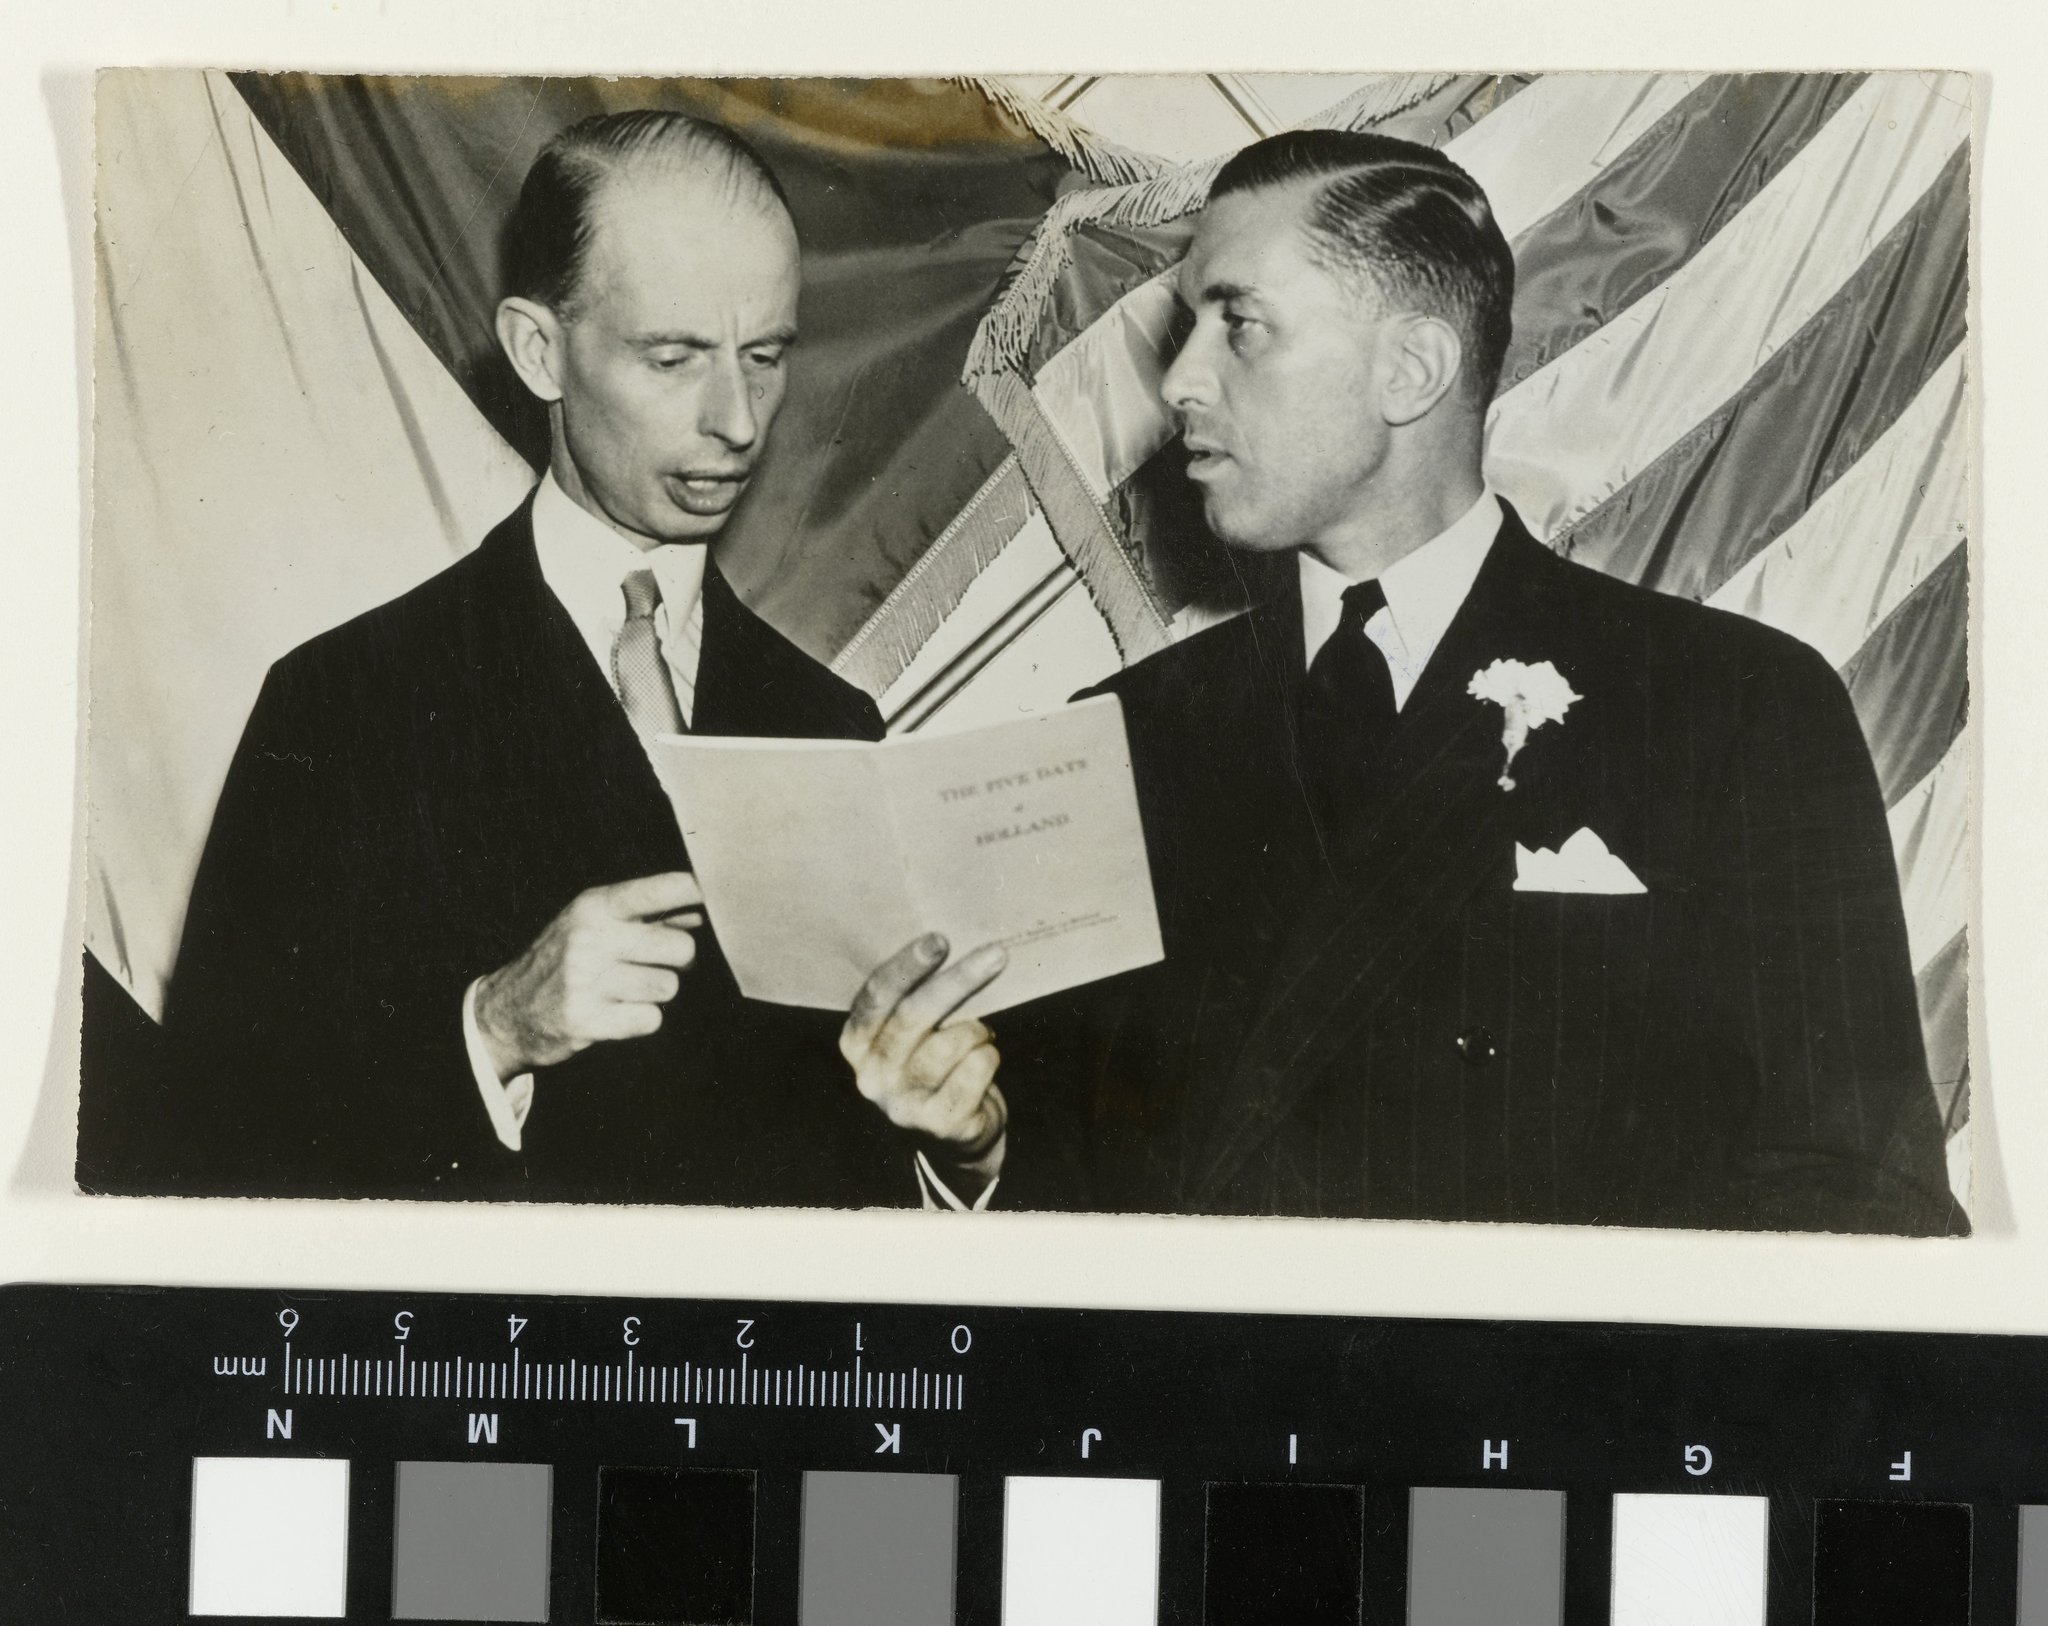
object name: photograph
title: Minister van Buitenlandse Zaken Eelco N. van Kleffens op bezoek in de Verenigde Staten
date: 1940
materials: photographic support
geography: new york city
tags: new york (city)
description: Eelco Nicolaas van Kleffens (1894-1983) was tijdens de Tweede Wereldoorlog de Nederlandse minister van buitenlandse zaken in Londen. Op de foto staat hij links. De foto is gemaakt tijdens het bezoek wat hij op 13 juni 1941 bracht aan Dr. N.A.C. Slotemaker de Bruine in de Verenigde Staten. De heer Slotemaker de Bruine was de directeur van het Netherlands Information Bureau te New York. Van Kleffens werd in 1939 Minister van Buitenlandse Zaken in het kabinet-De Geer II. Hij zette de toenmalige Nederlandse neutraliteitspolitiek voort. Op 10 mei 1940 ontving Van Kleffens een verklaring voor de Duitse aanval op Nederland van de Duitse gezant Graf Zech von Burkensroda. Hiermee was een einde gekomen aan de neutraliteit. Om steun te zoeken bij de geallieerden, vertrok Van Kleffens diezelfde ochtend met minister Charles Welter van Koloniën naar Londen. De rest van het kabinet zou later volgen. Tijdens de periode van de Nederlandse regering in Londen bleef Van Kleffens zijn ministerspost vervullen. Tijdens het kabinet-Gerbrandy II werd een tweede minister van buitenlandse zaken naast Van Kleffens benoemd. Met zijn diplomatieke kwaliteiten kon Van Kleffens vaak bemiddelen in conflicten tussen koningin Wilhelmina en minister-president Gerbrandy. In 1943 kwam hij met ideeën voor de oprichting van een Europese staat. In een radiotoespraak op 28 december 1943 pleitte hij voor het oprichten van een atlantisch bondgenootschap, de latere NAVO. Ook heeft hij aan de wieg gestaan van de Benelux. Deze foto is afkomstig uit de nalatenschap van kunstenaar Cor Visser.